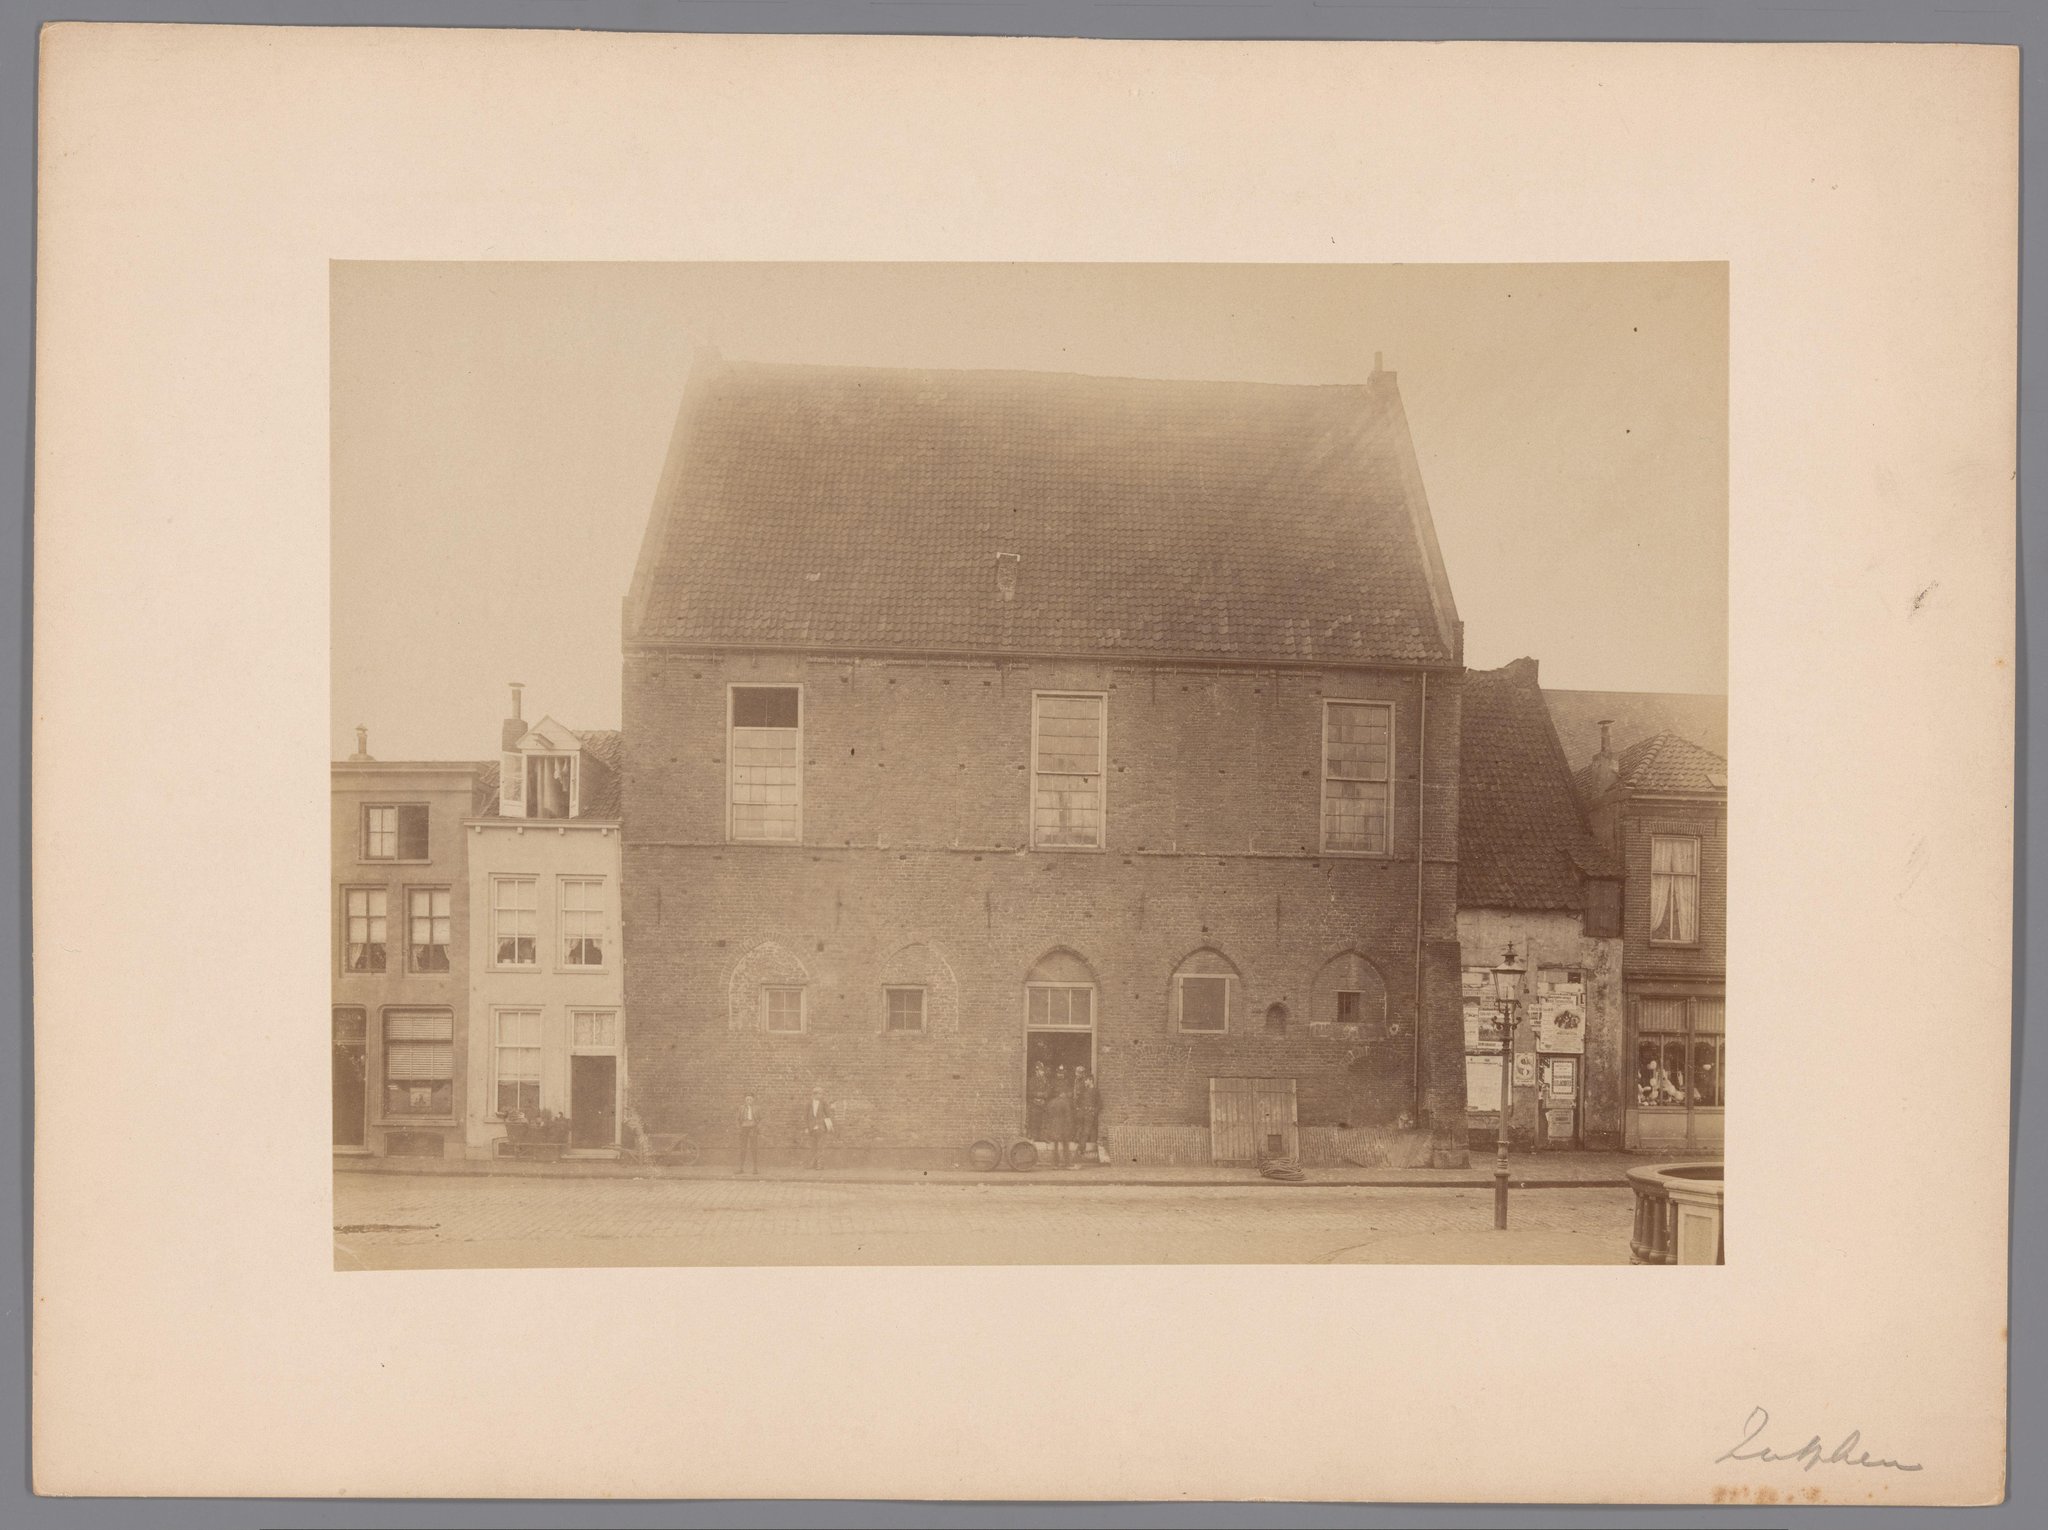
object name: photograph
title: Gezicht op de Broerenkazerne te Zutphen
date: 1890-1920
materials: cardboard, photographic support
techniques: albumen print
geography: zutphen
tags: barracks, street (+ city(-scape) with figures, staffage)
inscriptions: annotation: ‘Broerenkaserne / te / Zutphen (G.)’